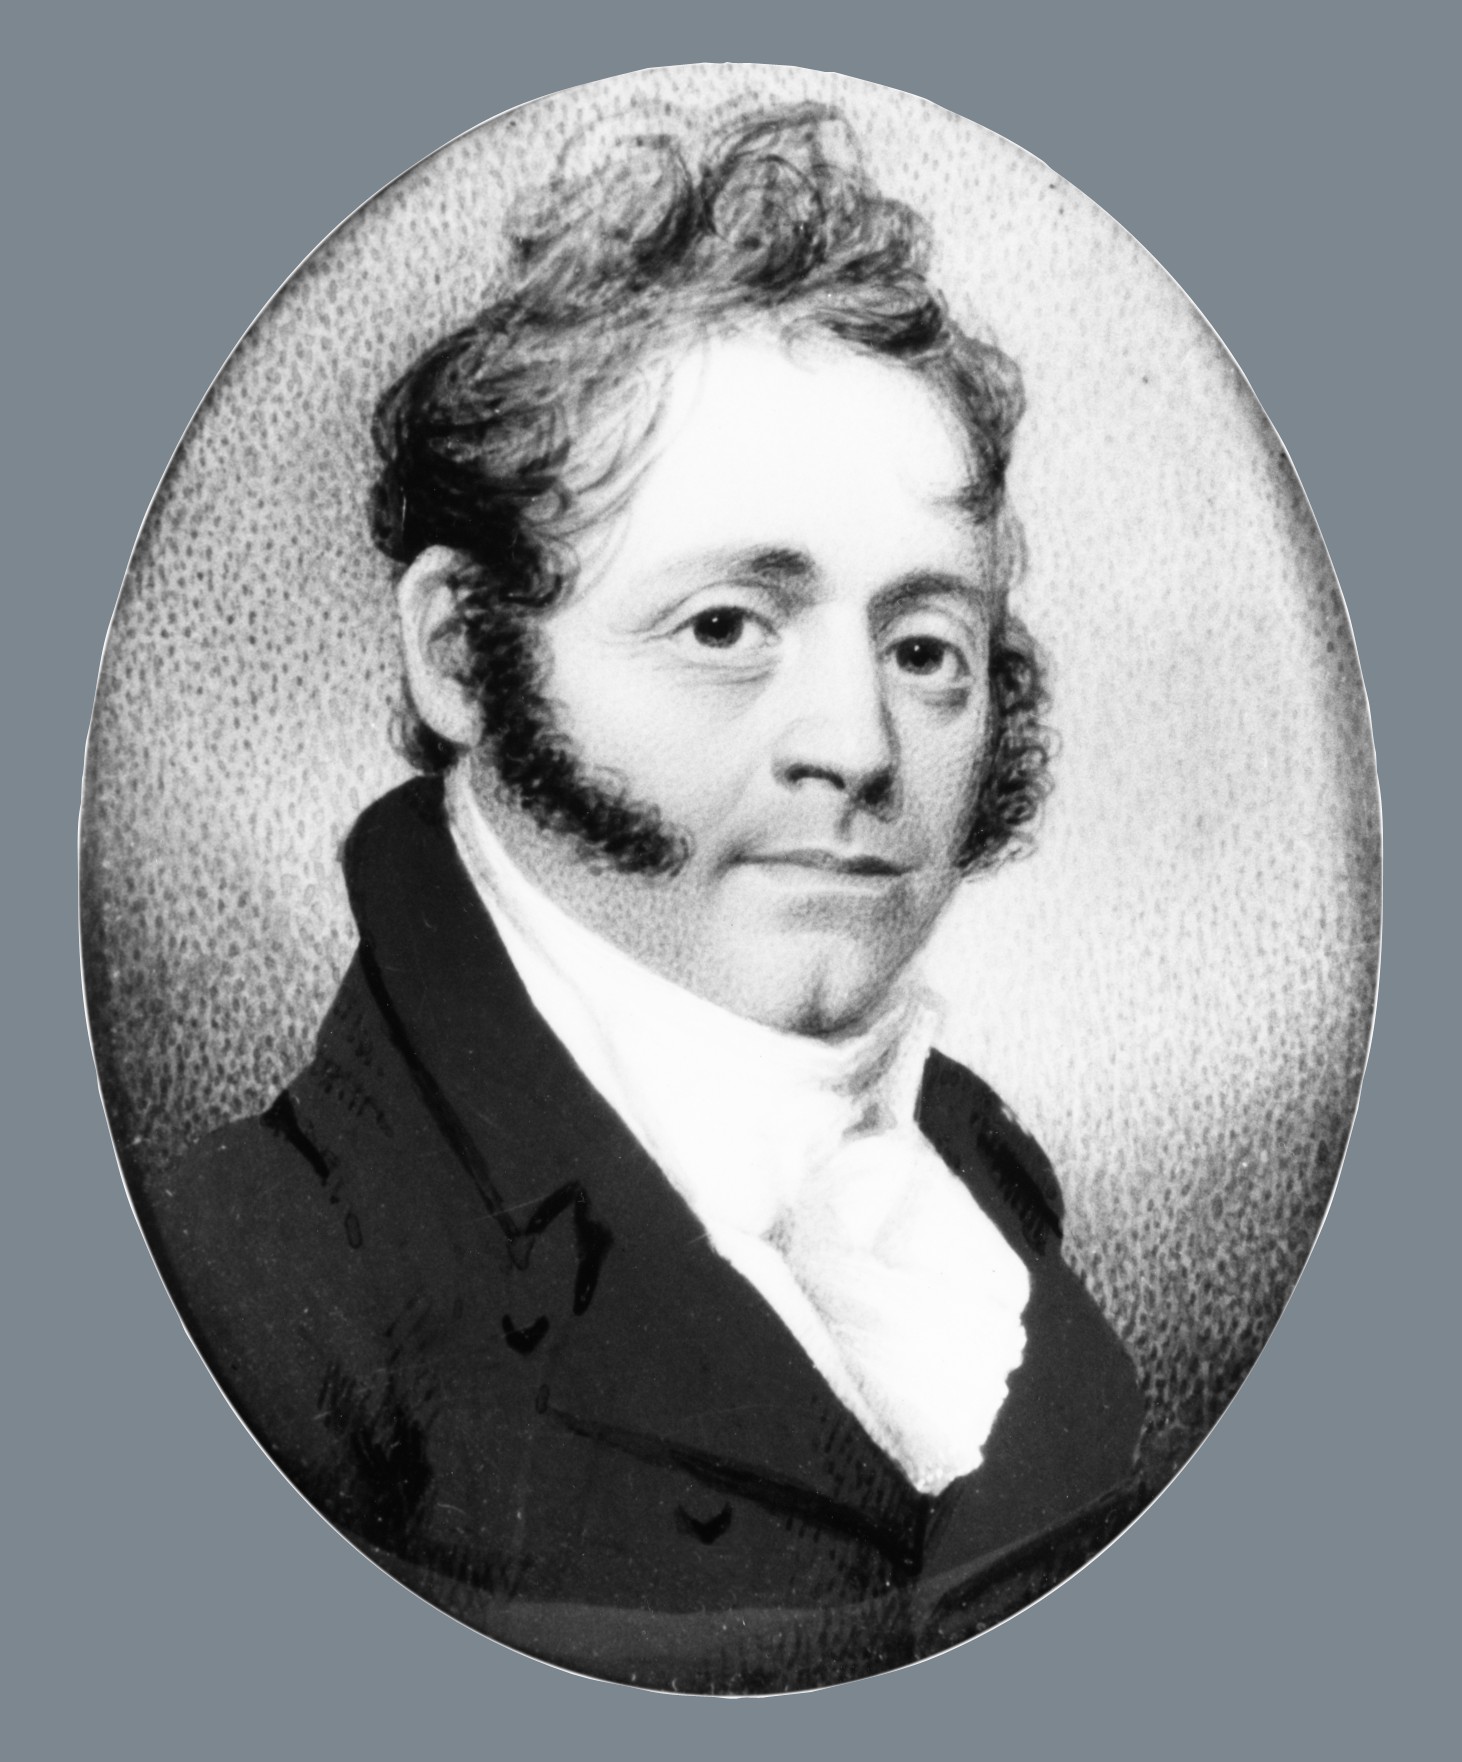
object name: painting, miniature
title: Dr. Richard A. Maupin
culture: american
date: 1820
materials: ivory, watercolor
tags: men,portraits